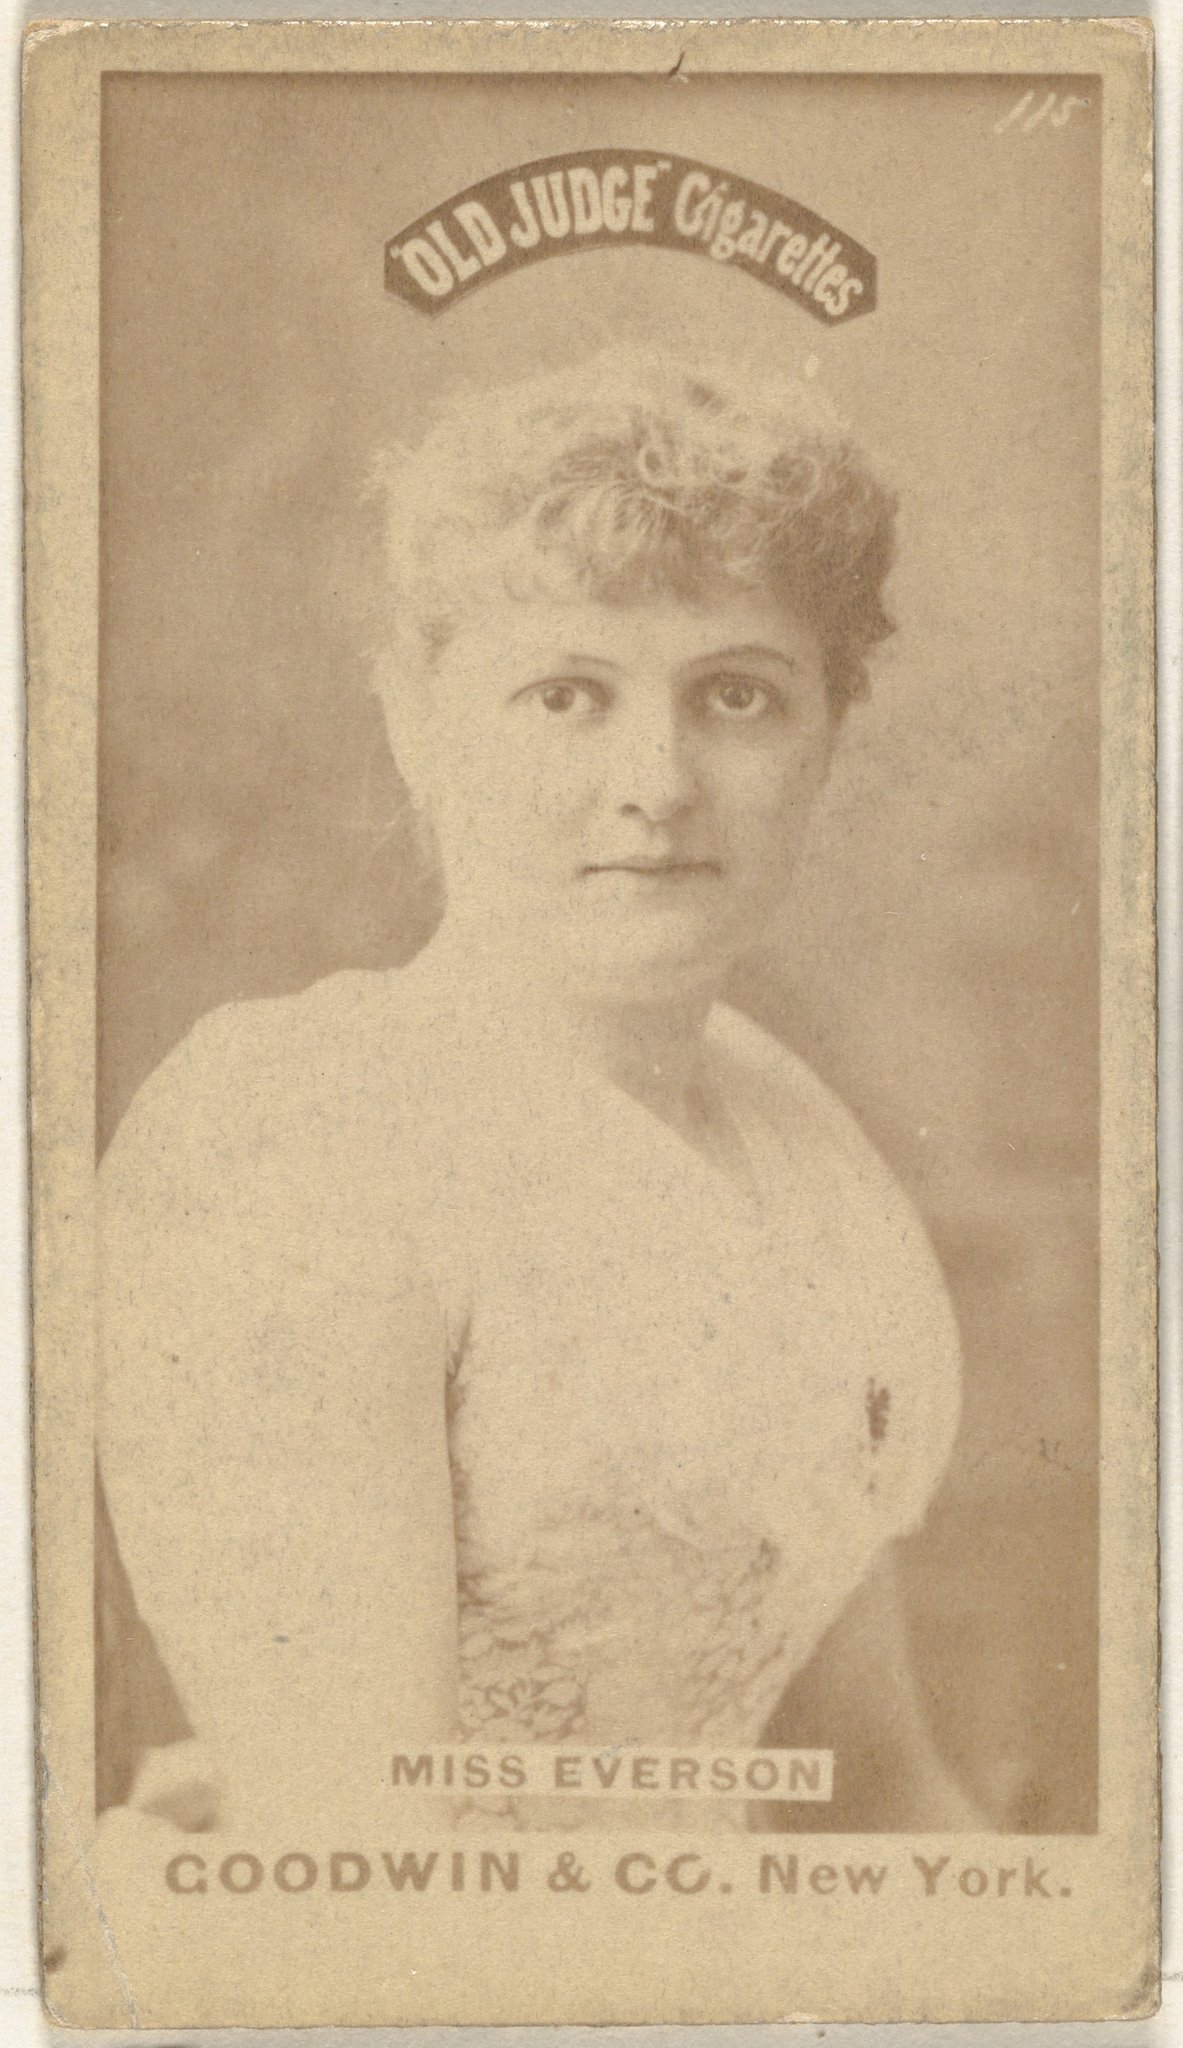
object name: photograph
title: Miss Everson, from the Actors and Actresses series (N171) for Old Judge Cigarettes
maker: goodwin & company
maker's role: publisher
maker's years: 1850-1950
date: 1886-1890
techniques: albumen silver print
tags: portraits,women,actresses